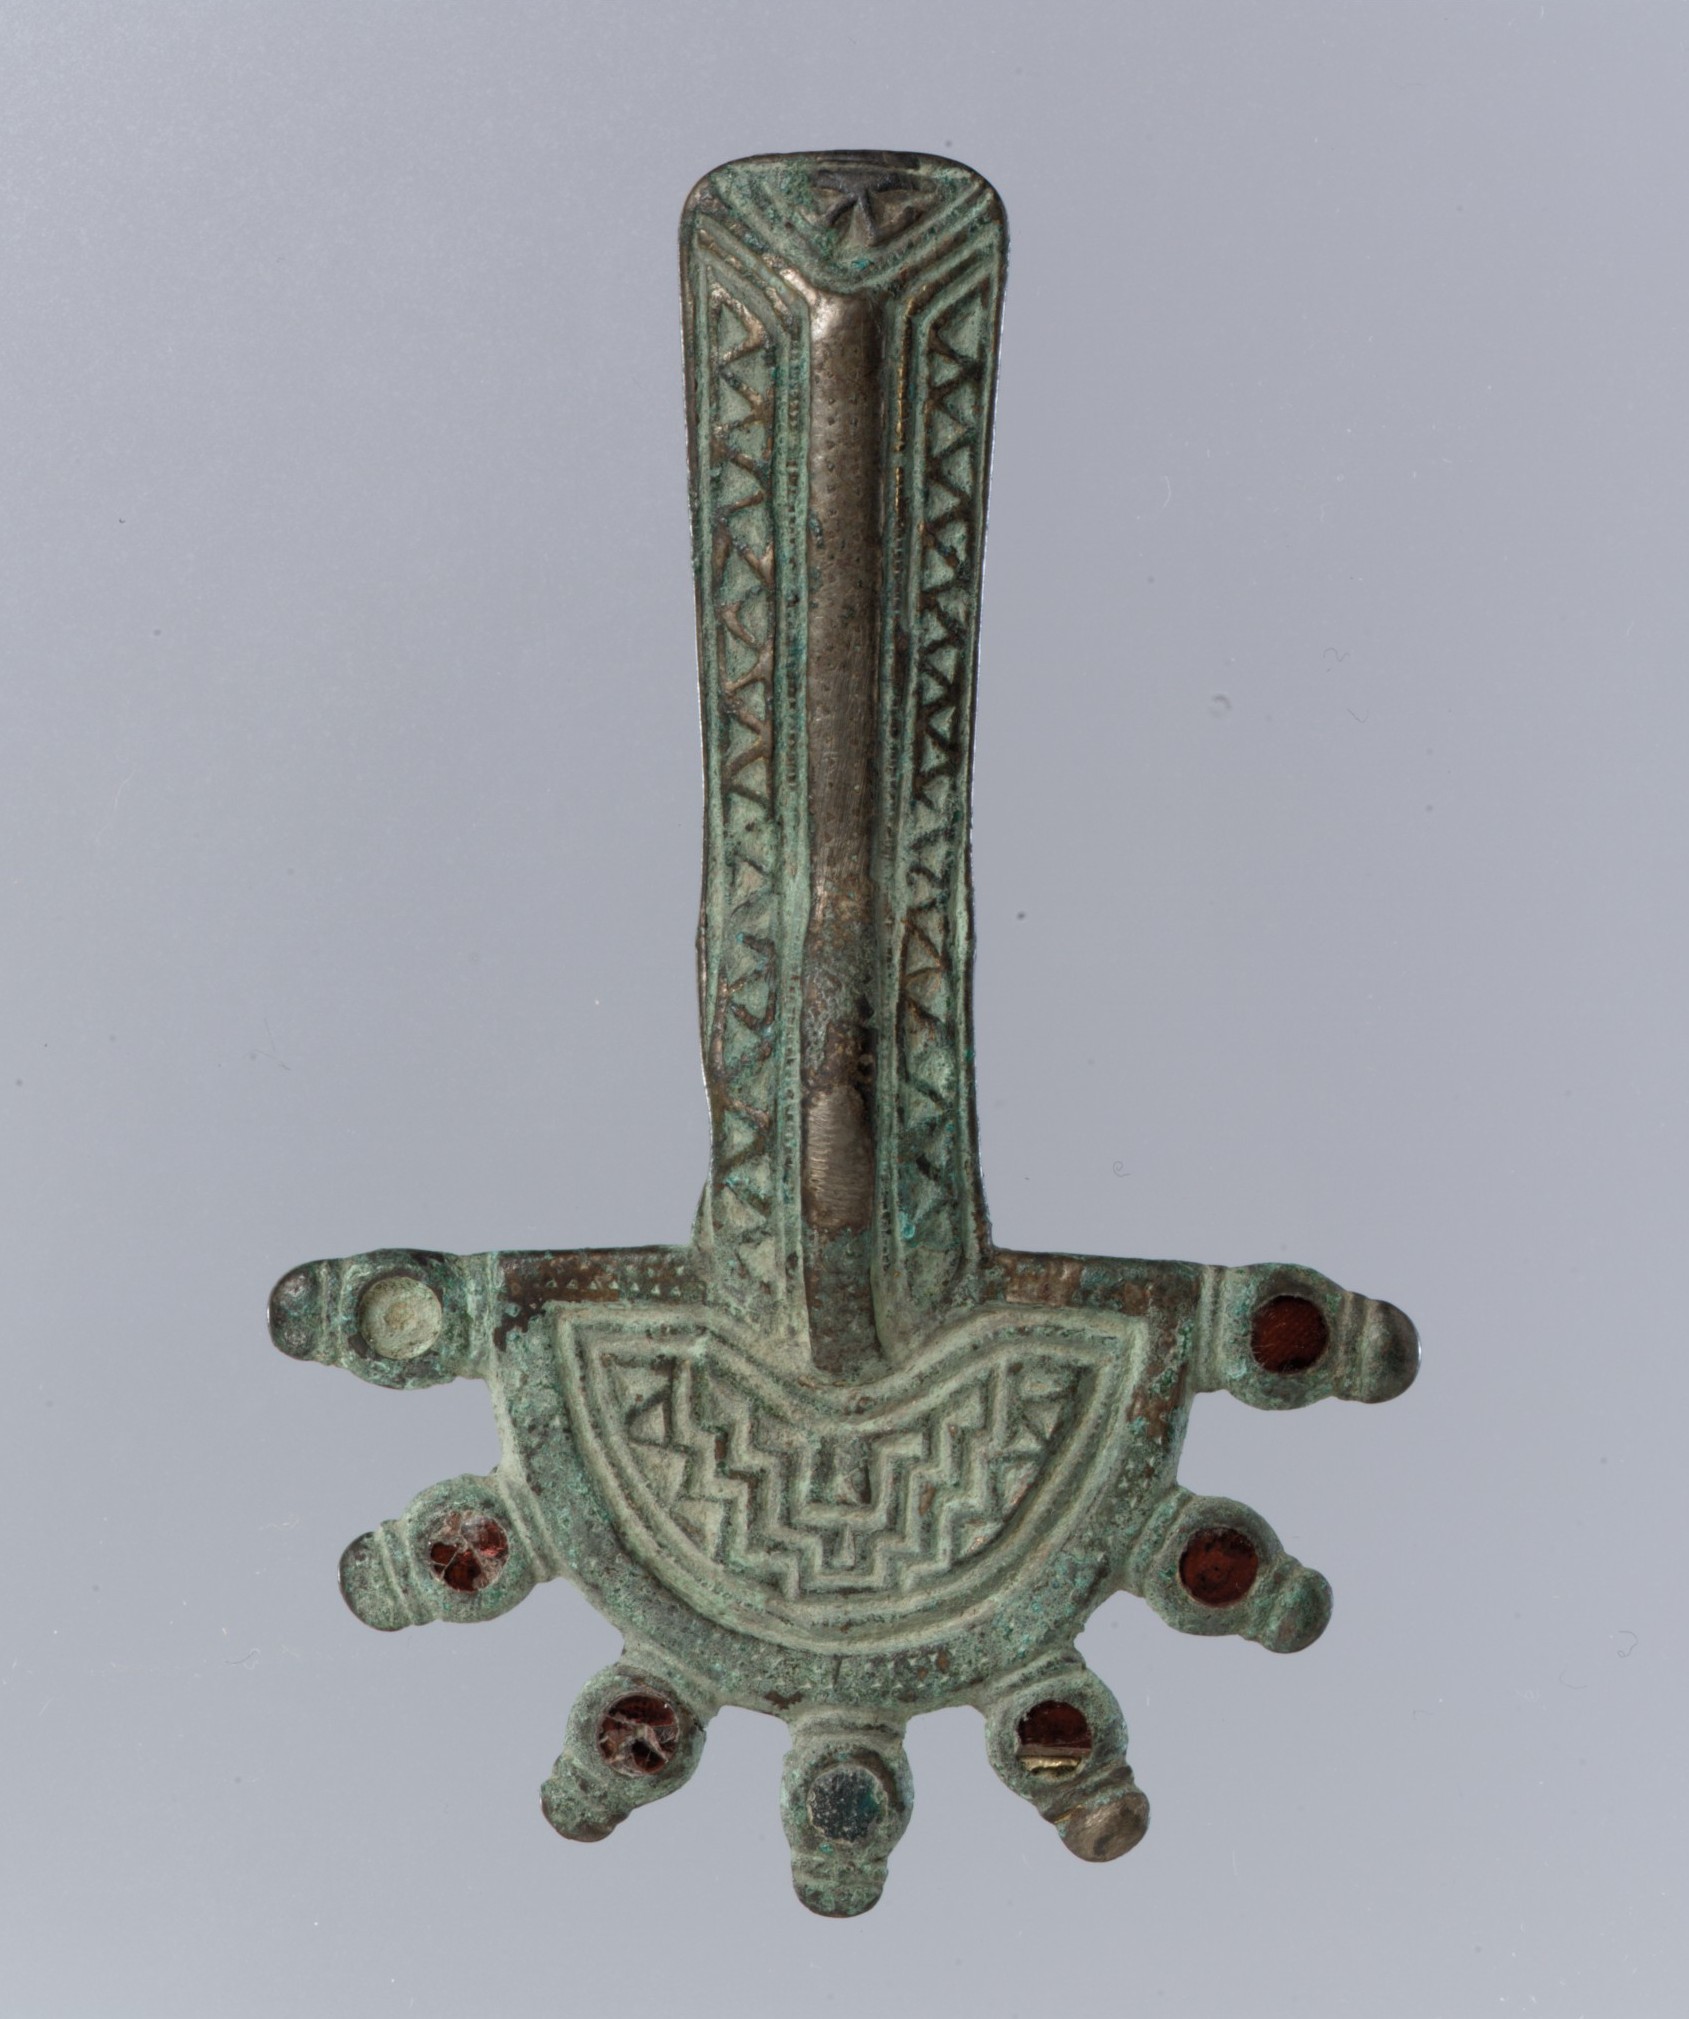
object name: brooch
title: Bow Brooch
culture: frankish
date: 500-550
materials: gemstone, glass, niello, silver gilt